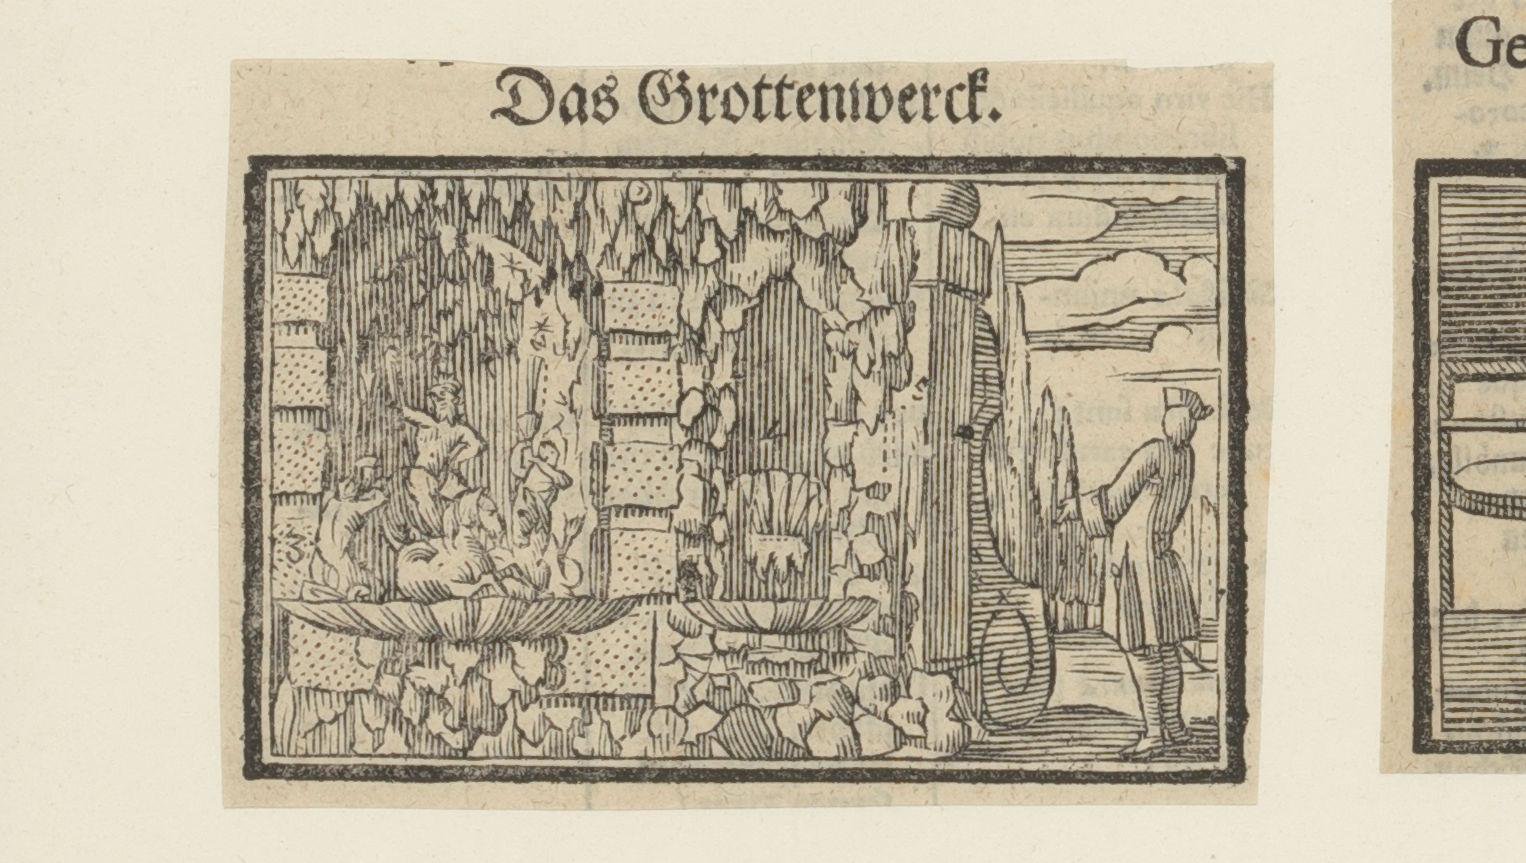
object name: book illustration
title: Bouwen van een schelpengrot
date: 1719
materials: paper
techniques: letterpress printing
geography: nuremberg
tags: handicrafts, craftsman at work, handicrafts ~ stone, cave, grotto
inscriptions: stamp, collector's mark: Lugt 1641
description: Volgens de beschrijving een afbeelding van een gebouwtje met decoraties van schelpen en koralen. Rechts een nis met waterval en links een fontein met beelden. Onderwerpsrubrieken binnen de Atlas Zeden en Gewoonten: Handel, Nijverheid en Verkeer, Beroep en bedrijf, Complete suites.